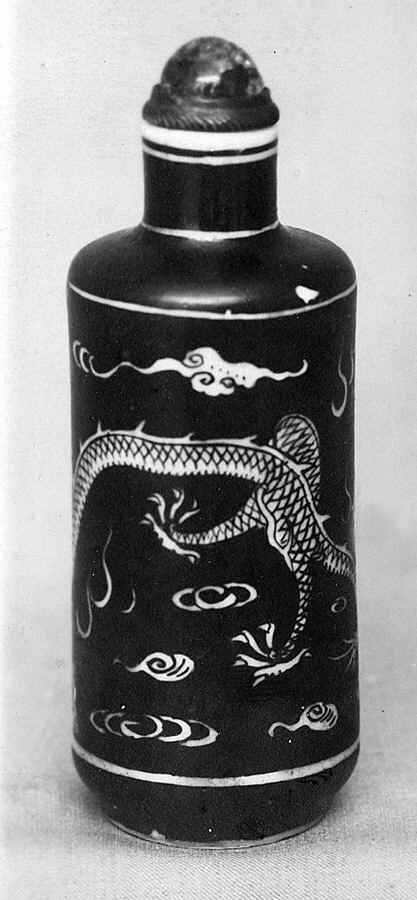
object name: snuff bottle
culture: chinese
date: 1801-1900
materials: porcelain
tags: dragons